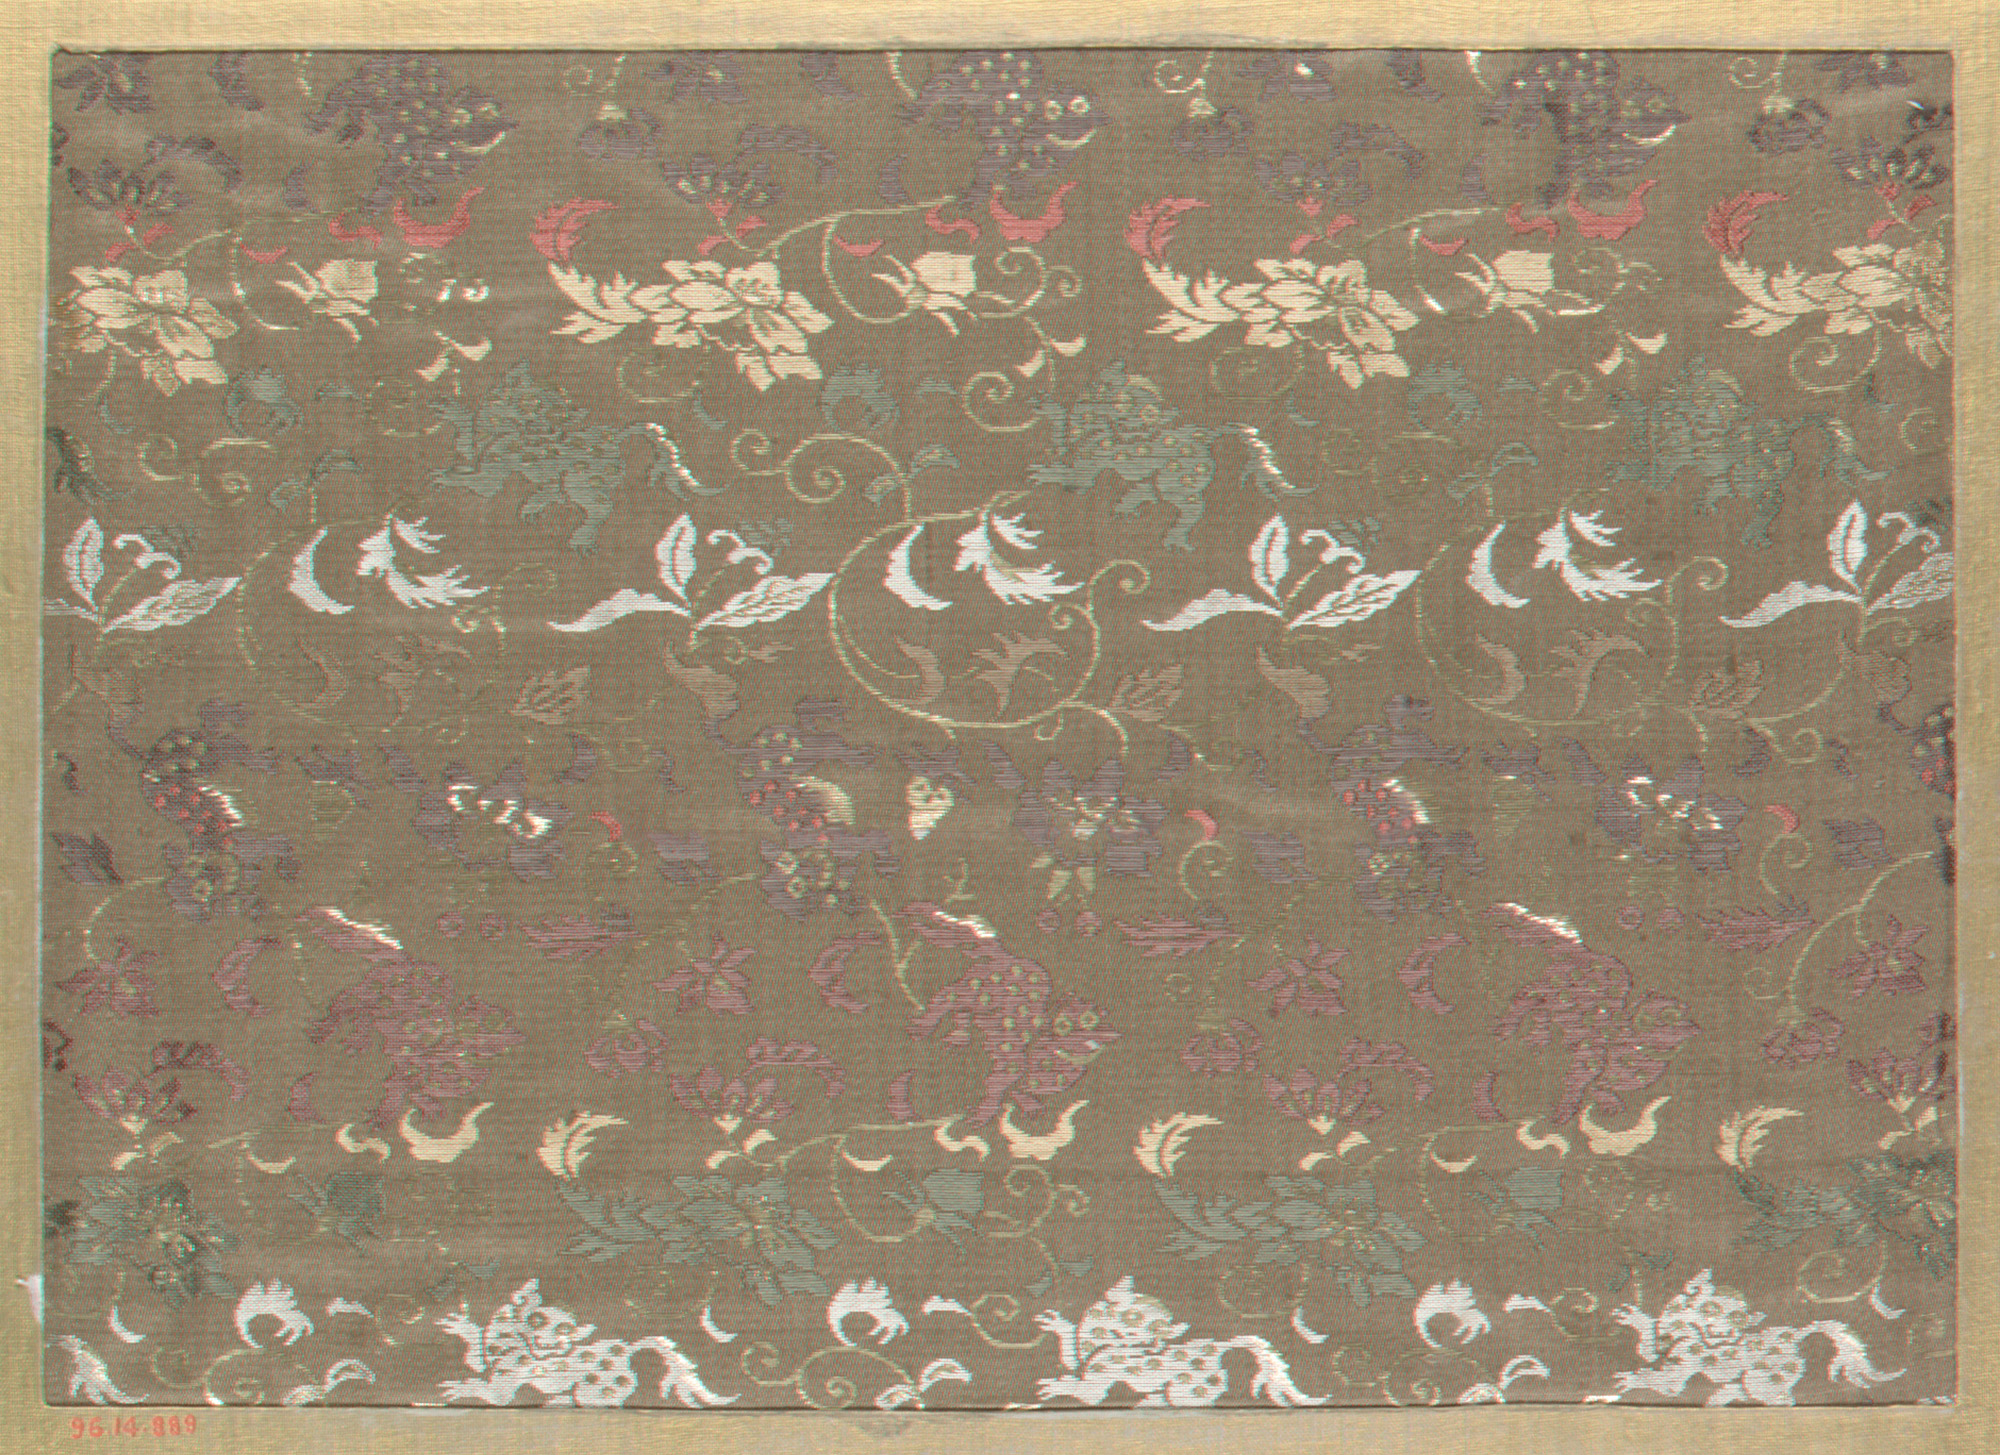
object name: piece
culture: japanese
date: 1701-1900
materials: silk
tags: animals